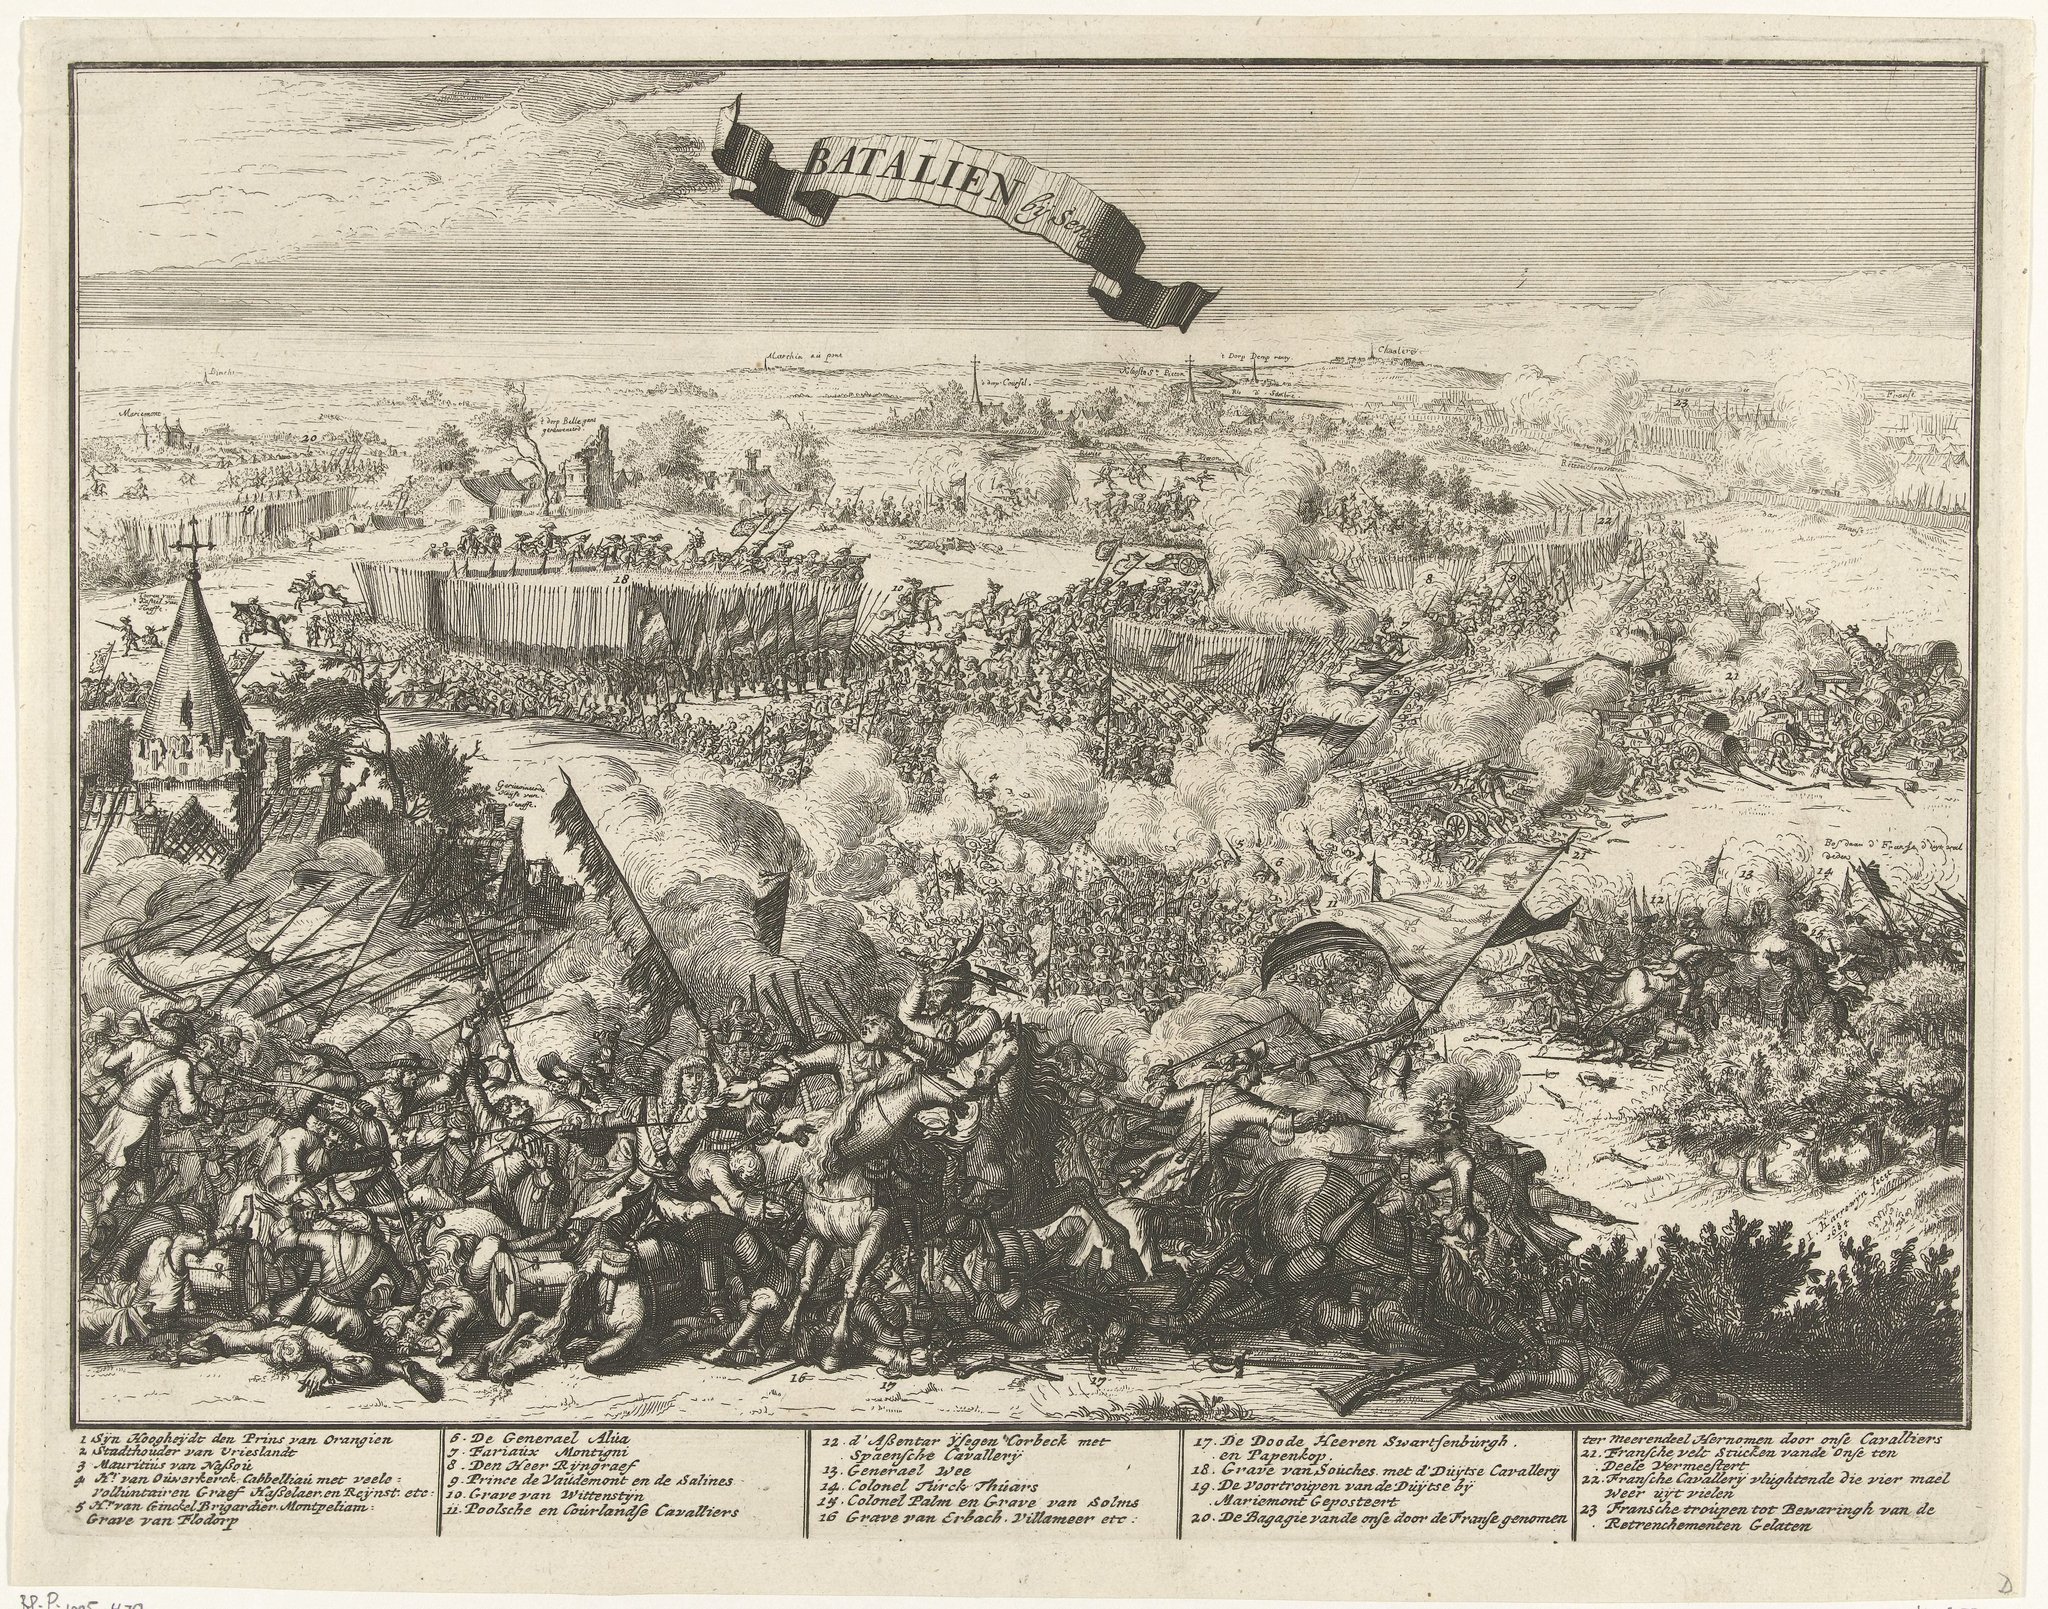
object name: history print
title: Slag bij Seneffe, 1674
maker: jacobus harrewijn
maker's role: print maker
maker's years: 1660-1740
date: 1610-1684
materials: paper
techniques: etching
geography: low countries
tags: the hague, william iii (prince of orange and king of england, scotland, and ireland), paris, lodewijk ii de bourbon-condé (hertog van enghien), battle (+ land forces)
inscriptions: collector's mark: Lugt 2228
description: De slag bij Seneffe tussen het leger van de geallieerde Spaanse, Staatse en keizerlijke troepen onder Willem III en het Franse leger onder maarschalk Condé op 11 augustus 1674. In het onderschrift de legenda 1-23 in het Nederlands. Bovenaan de titel op een lint.